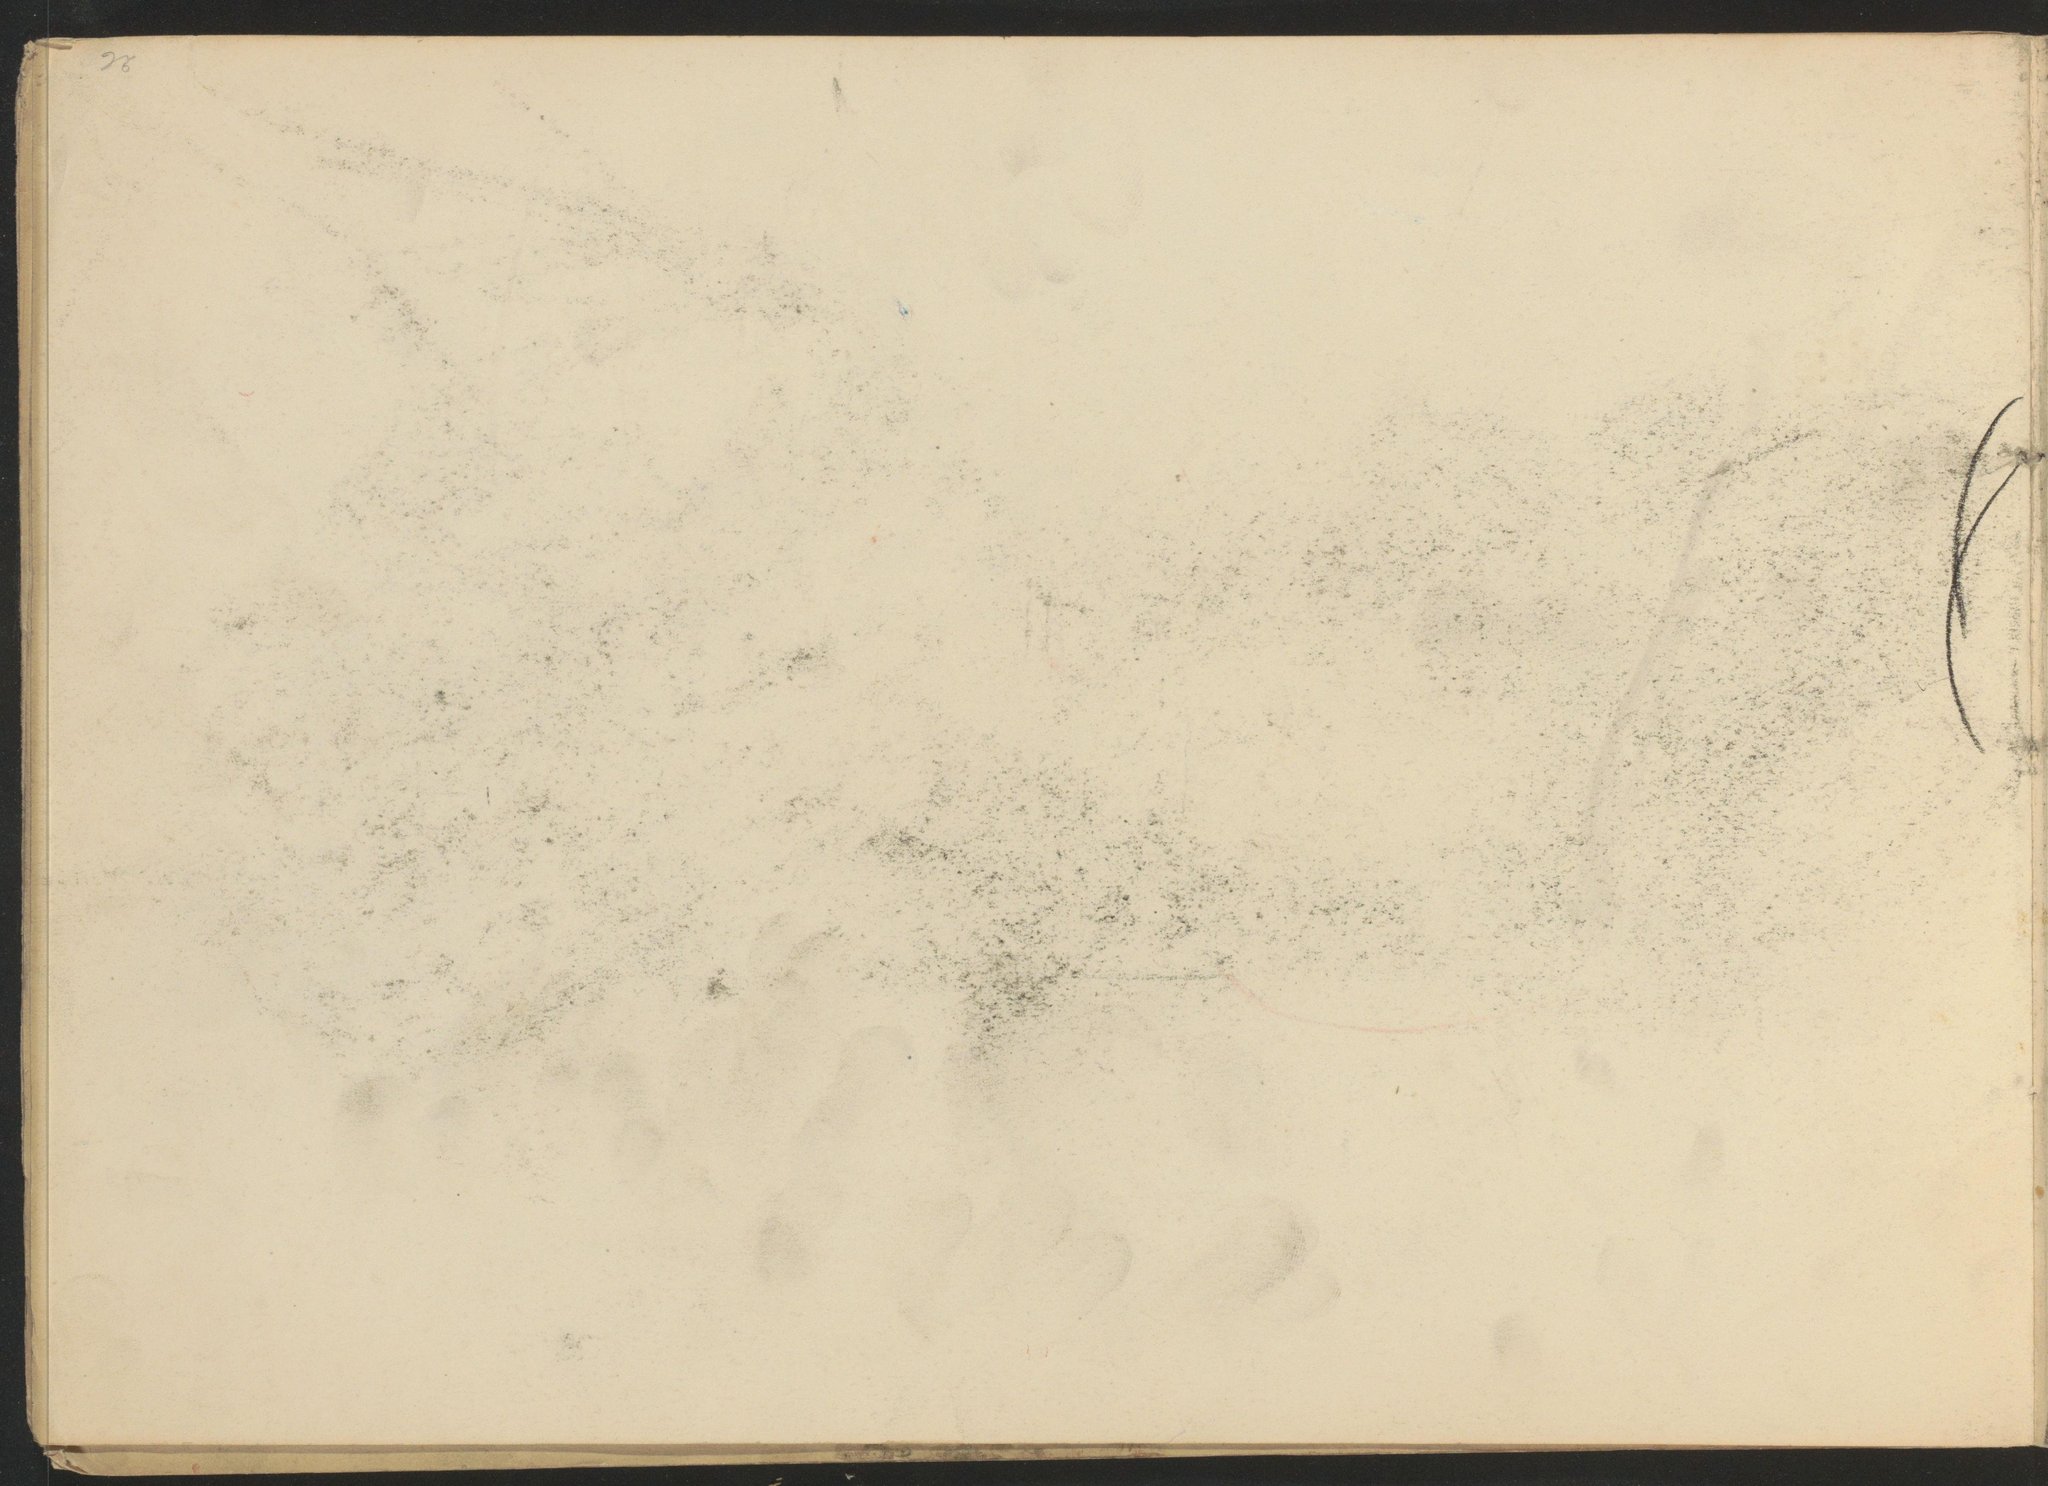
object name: sketchbook leaf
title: Studie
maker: isaac israels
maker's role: draughtsman, painter, print maker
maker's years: 1865-1934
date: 1875-1934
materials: chalk, paper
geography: the hague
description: Blad 13 verso uit schetsboek XII met 19 bladen.